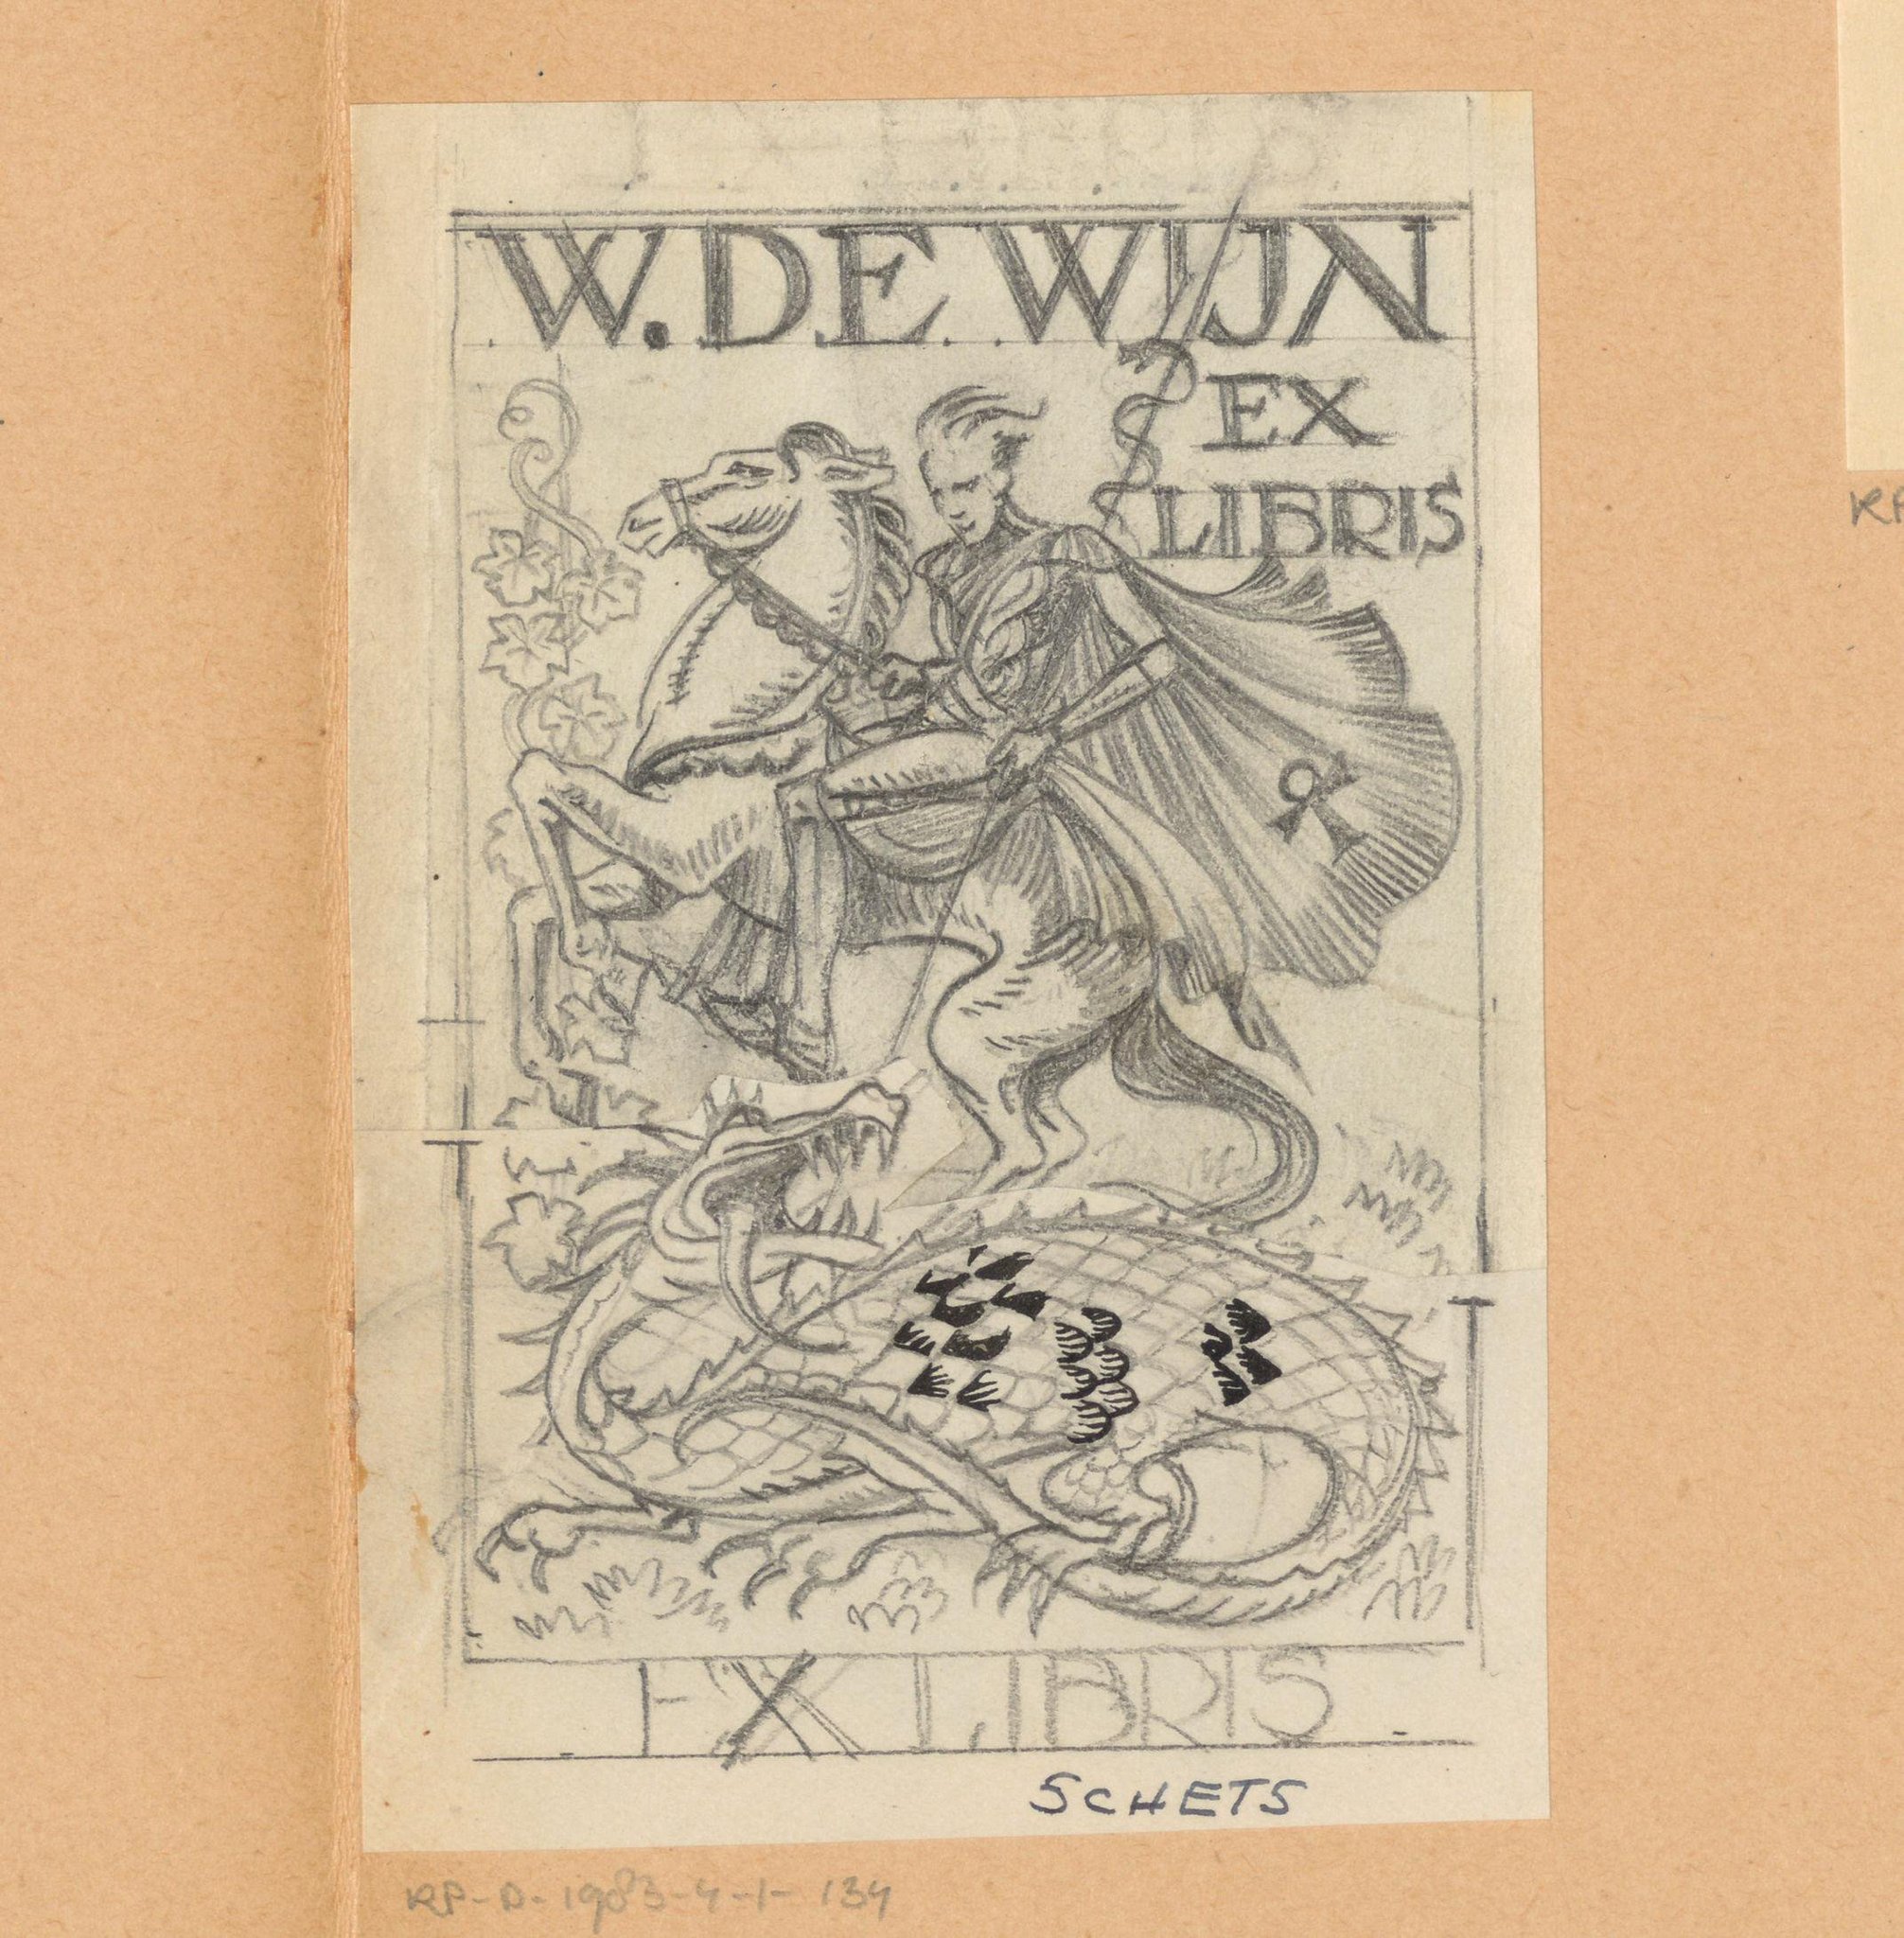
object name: design drawing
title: Ontwerptekening voor ex libris van W. de Wijn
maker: otto verhagen (i)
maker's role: draughtsman, print maker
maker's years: 1885-1951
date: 1941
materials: ink, paper, pencil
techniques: drawing, pen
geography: netherlands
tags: vine, dragon, horse, aesculapian sign, the warrior martyr george (georgius); possible attributes: banner (red cross on white field), (red) cross, dragon, (white) horse, broken lance, shield (with cross), sword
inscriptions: inscription: ‘Schets’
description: Ontwerp voor een arts. Met zijn lans, tevens aesculaap, doodt hij de draak die staat voor ziekte. De Wijn was werkzaam in Ridderkerk, vandaar dat gekozen is voor Sint Joris met de draak.